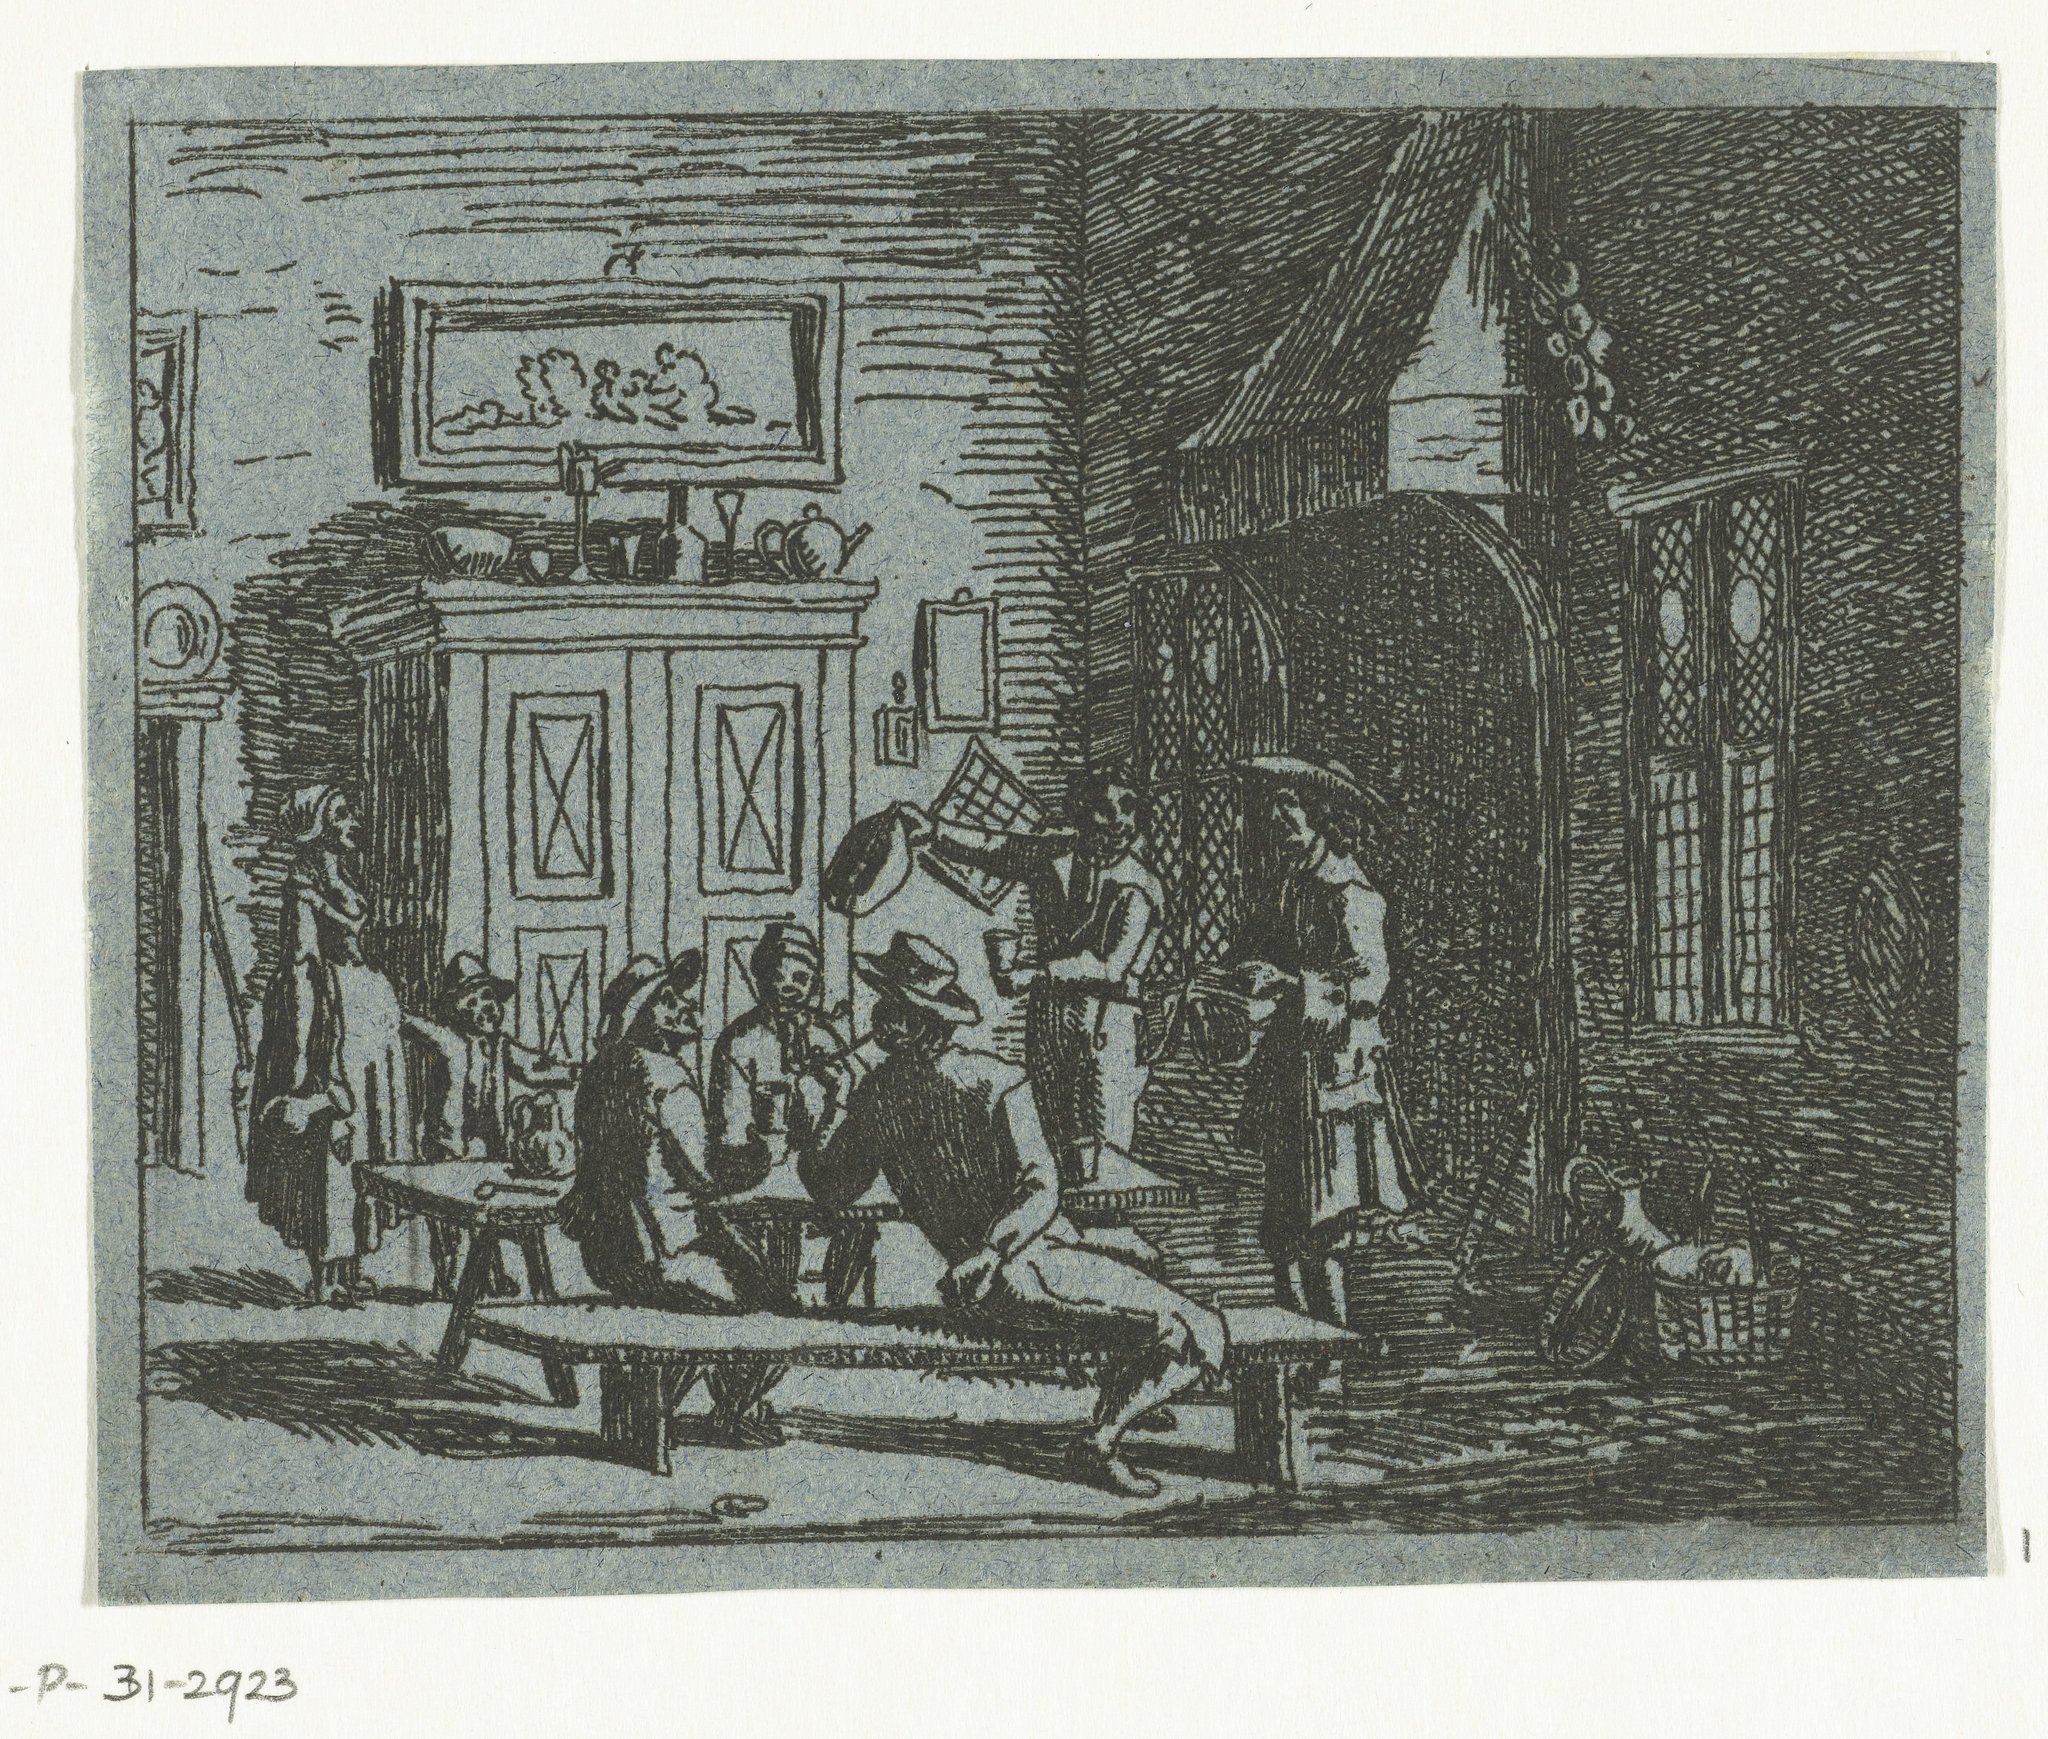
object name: print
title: Interieur van een herberg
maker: anthonie van den bos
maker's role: draughtsman, print maker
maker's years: 1763-1838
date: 1778-1838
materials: paper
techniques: etching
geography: netherlands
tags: indoor recreation (+ service ~ indoor recreation), inn, coffee-house, public house, etc. (+ waiter, waitress, etc.), reading to somebody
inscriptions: collector's mark: Lugt 2228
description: Een groep mannen zit aan tafel te drinken en pijp te roken. Een man staat voor de schouw en leest voor uit een pamflet. Een dienstmeid die net nieuwe drank komt brengen blijft staan en luistert aandachtig naar de man.